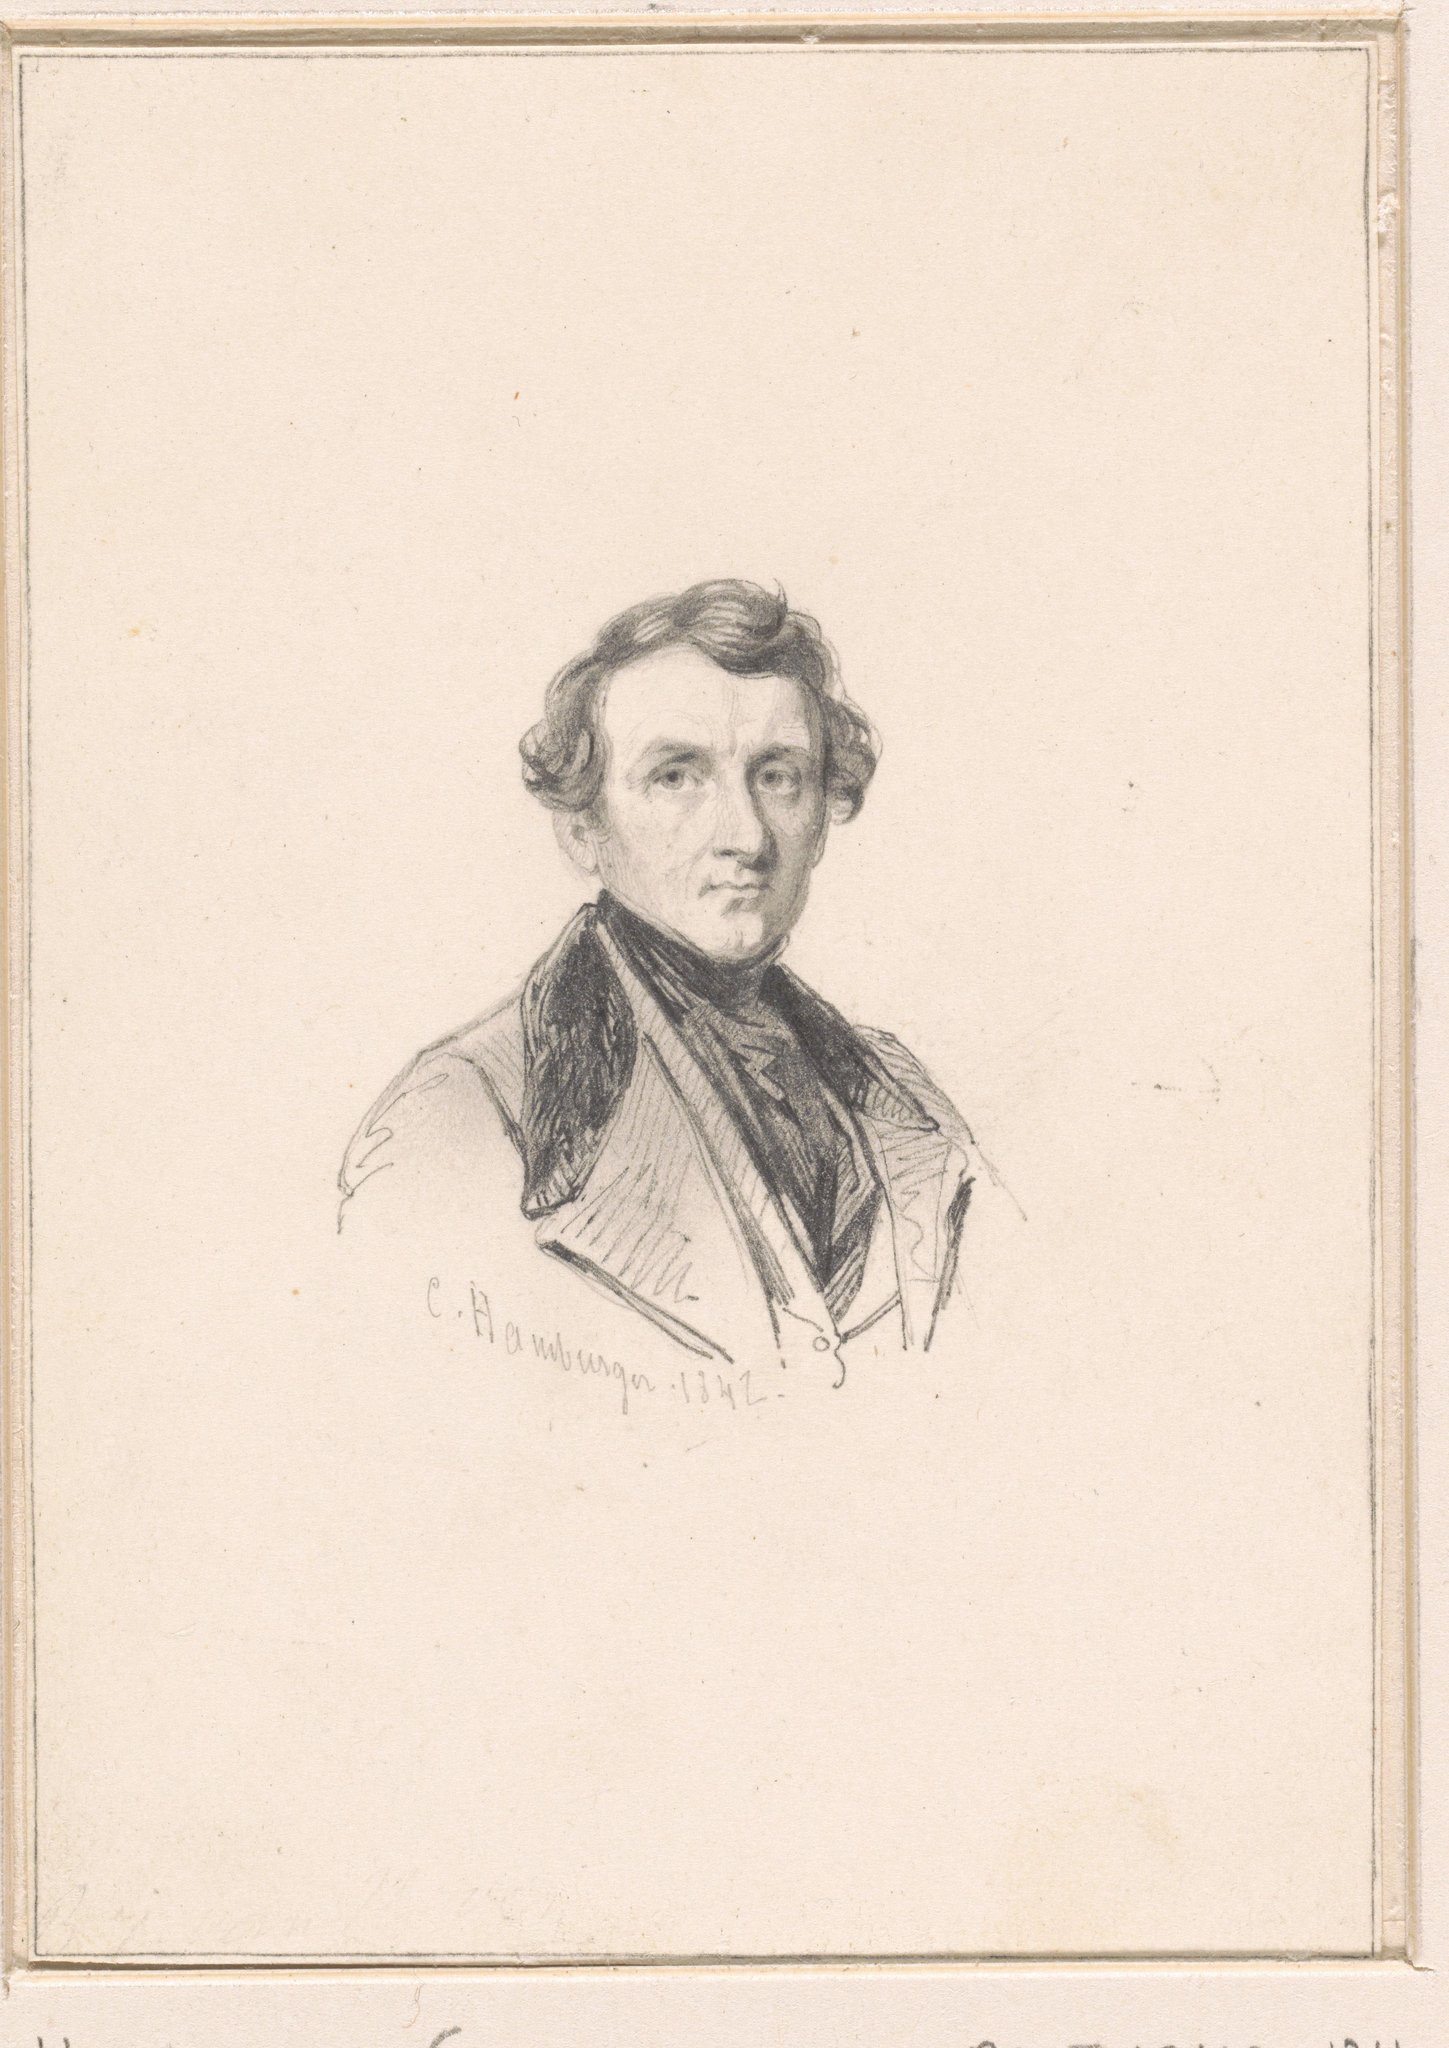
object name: drawing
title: Portret van Bartholomeus Johannes van Hove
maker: coenraad hamburger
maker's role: draughtsman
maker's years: 1809-1891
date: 1842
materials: paper, pencil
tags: the hague, painter, print maker, draughtsman, bartholomeus johannes van hove, historical persons, portrait, self-portrait of painter, portrait, self-portrait of artist, portrait, self-portrait of draughtsman